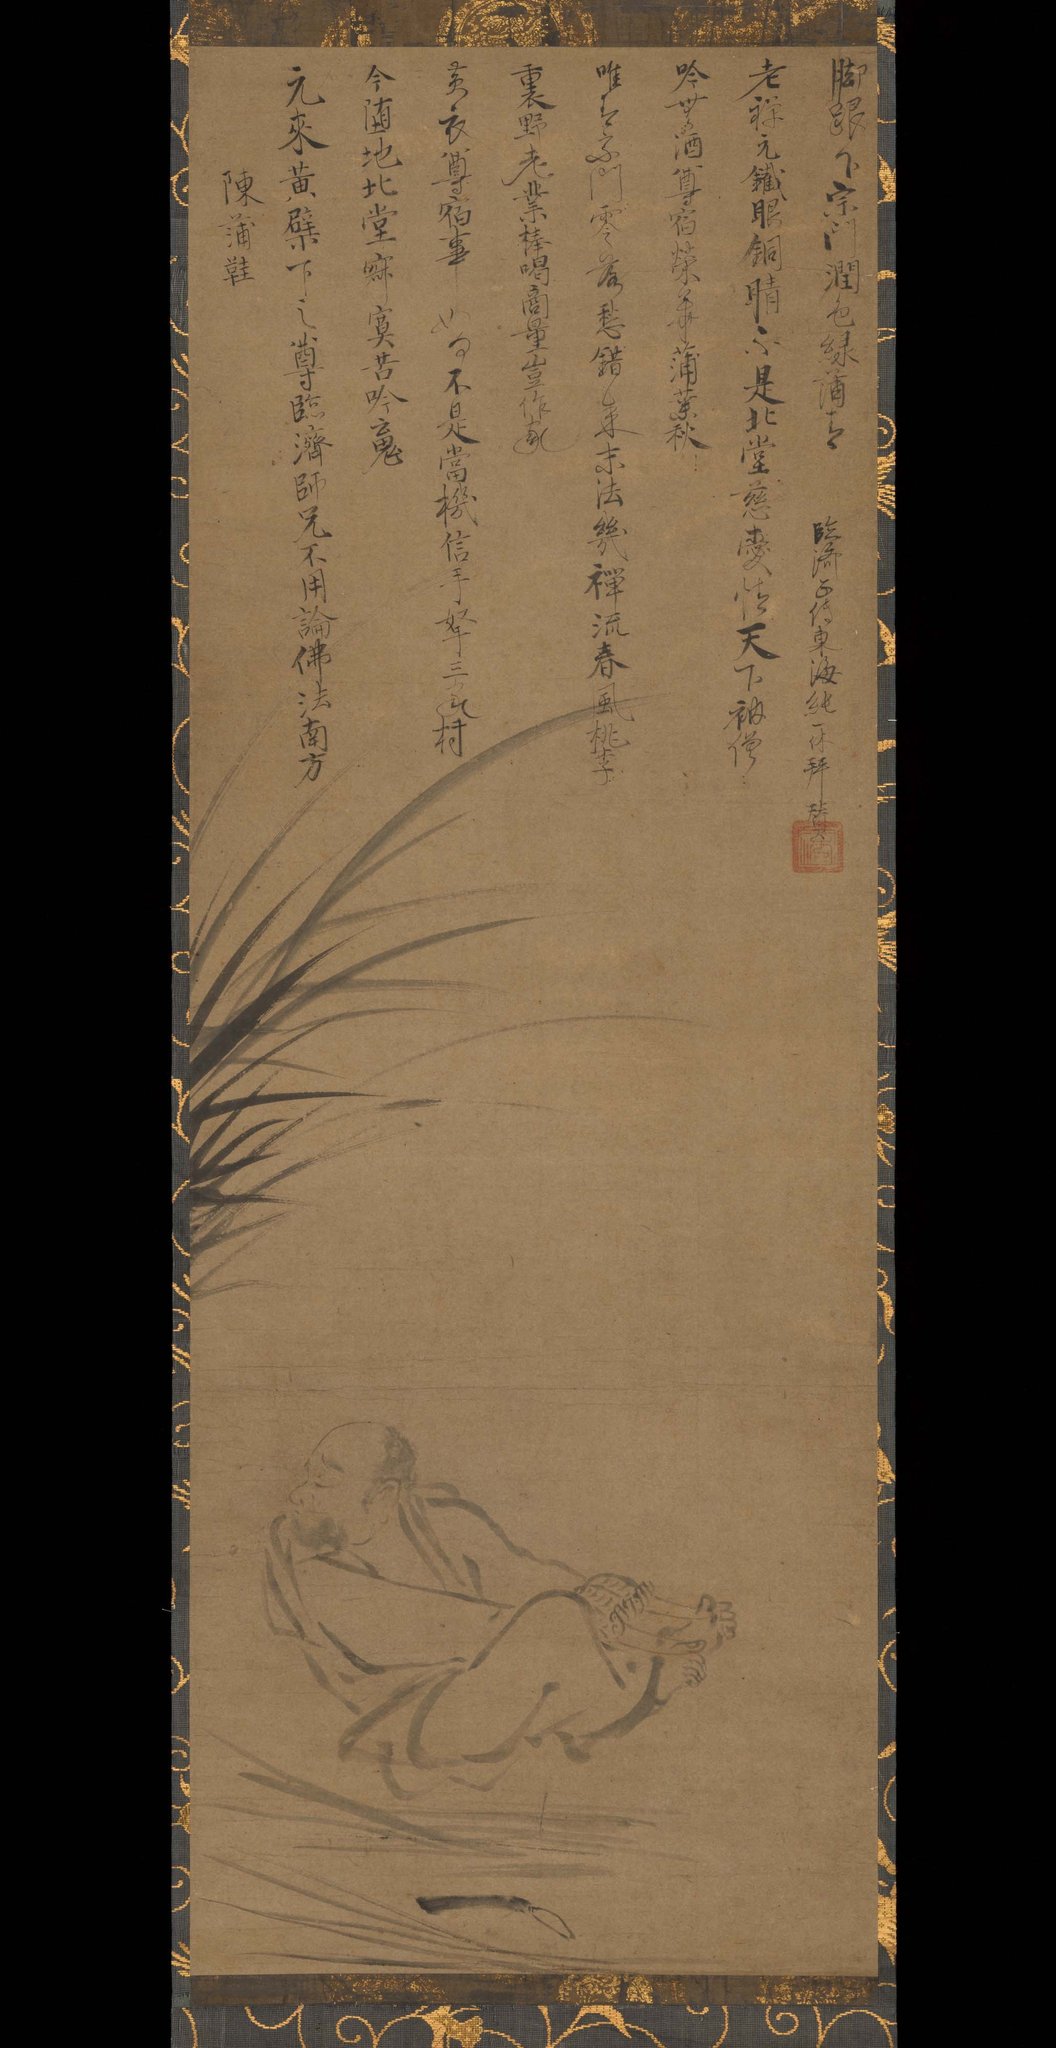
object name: hanging scroll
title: Rush-Sandal Chen (Chen Puxie)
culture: japanese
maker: ikkyū sōjun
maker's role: artist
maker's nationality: japanese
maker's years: 1394-1481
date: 1467-1500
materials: ink, paper